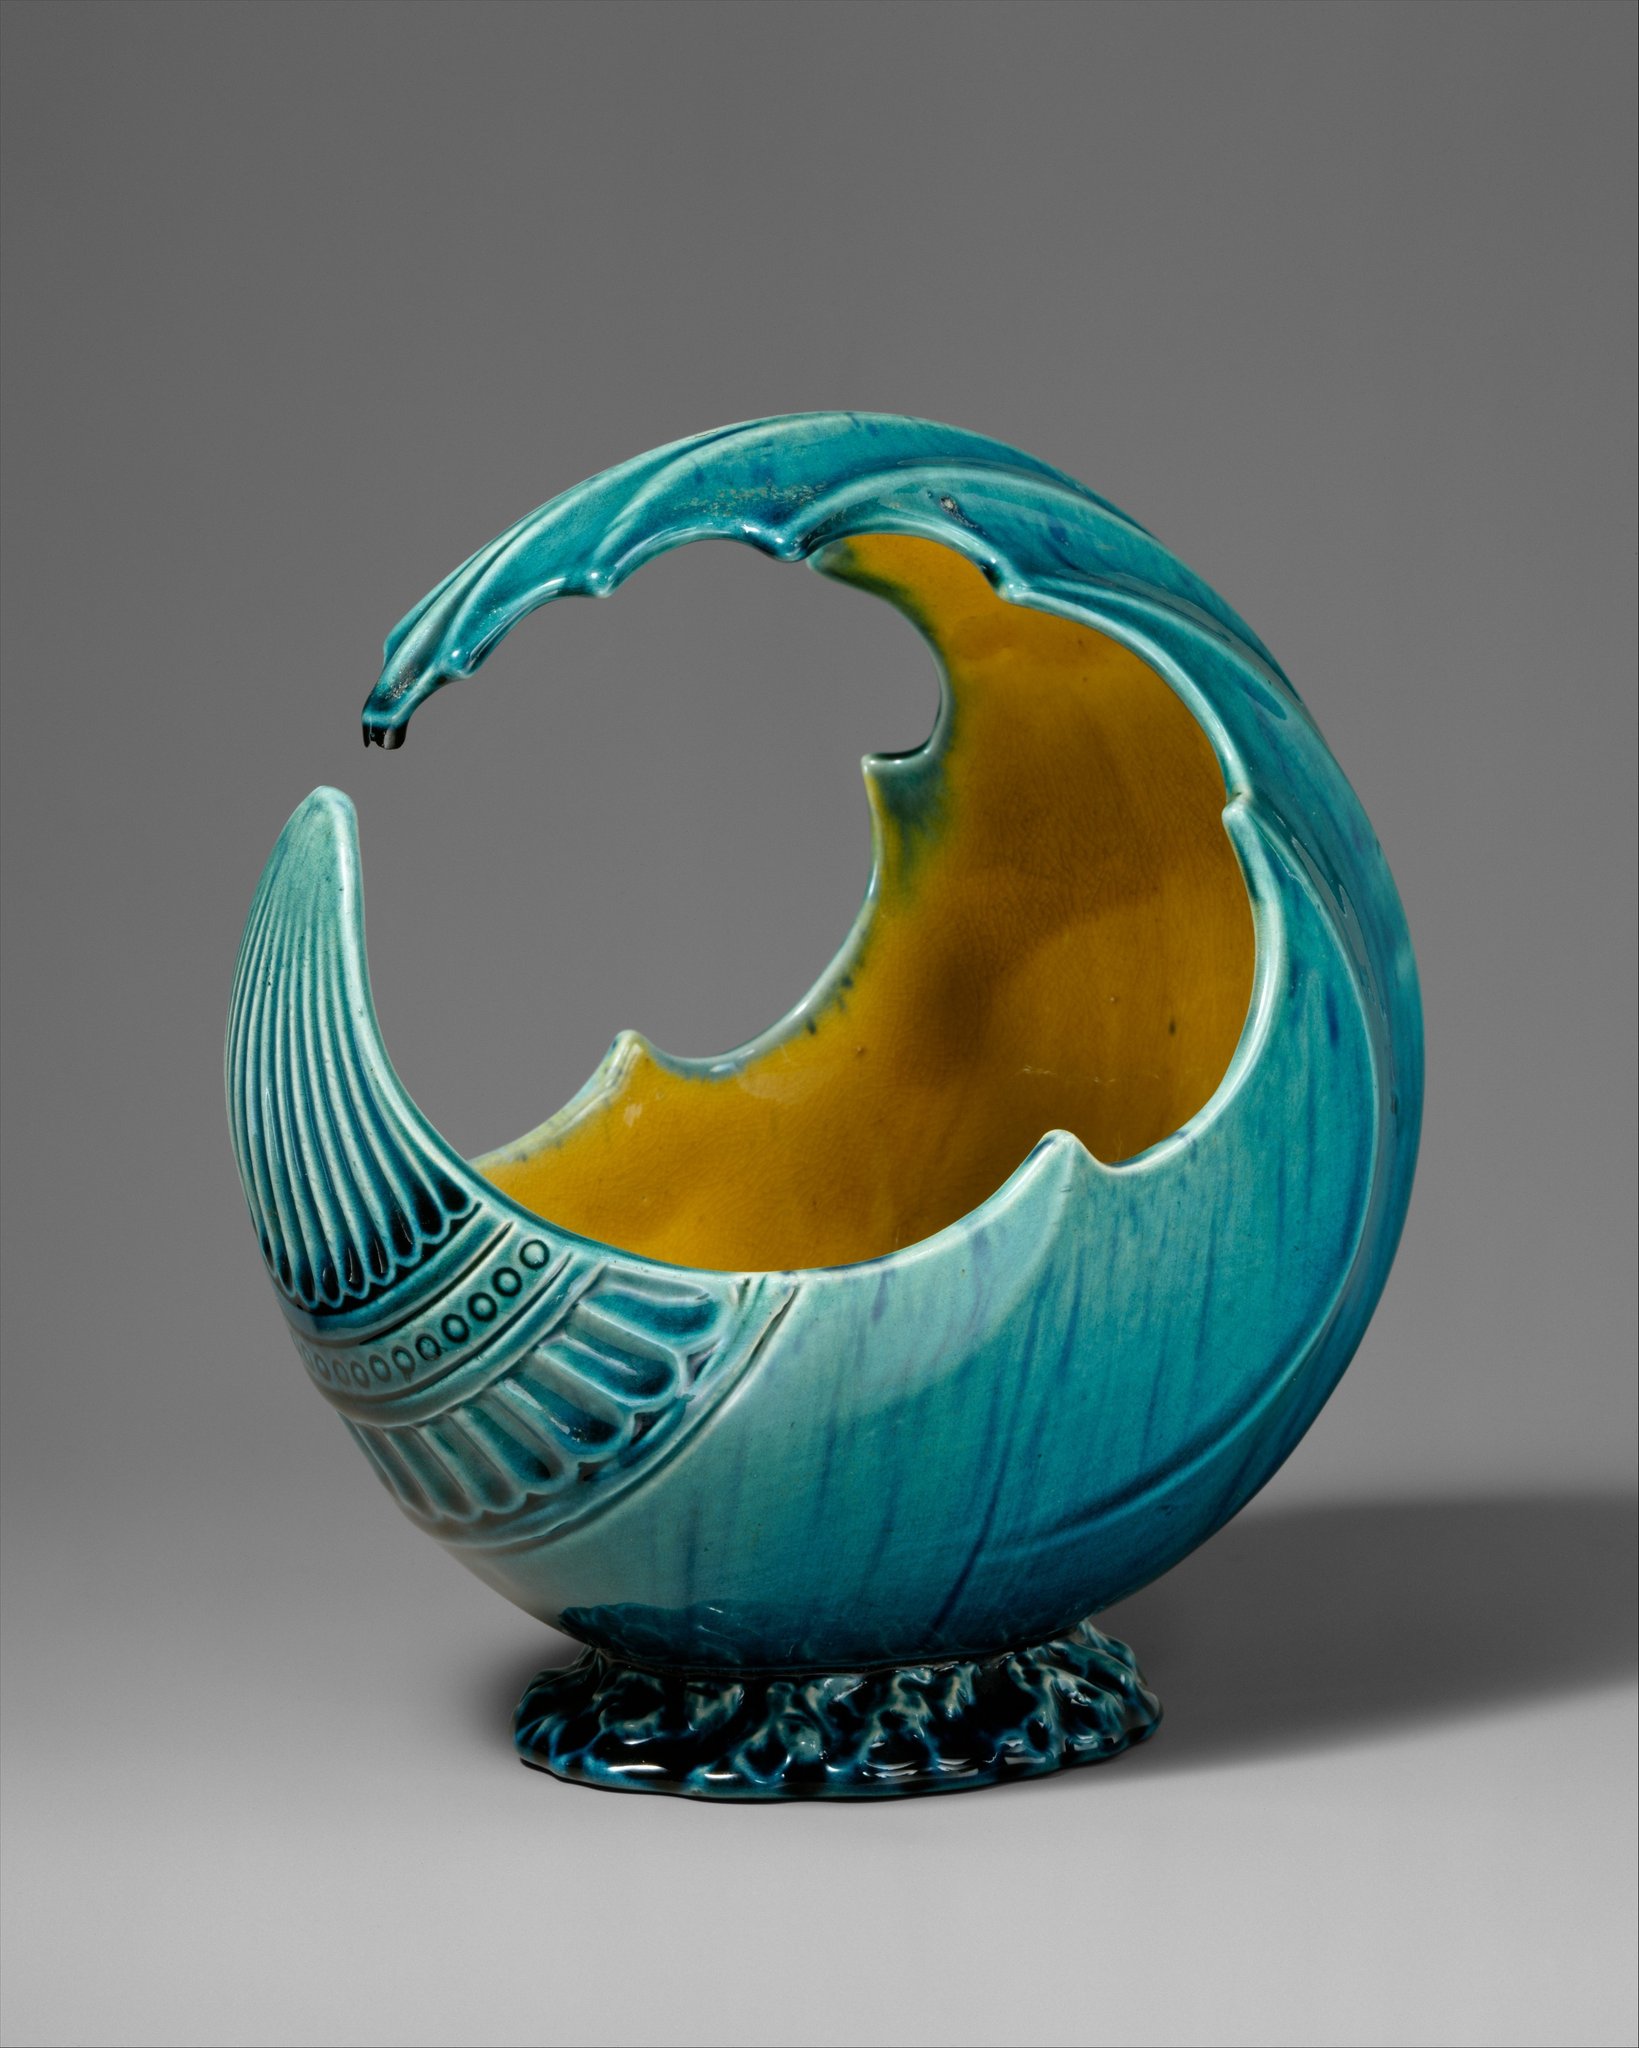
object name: wave bowl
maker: christopher dresser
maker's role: designer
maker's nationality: british, scottish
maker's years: 1834-1904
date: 1880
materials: earthenware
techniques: glazing